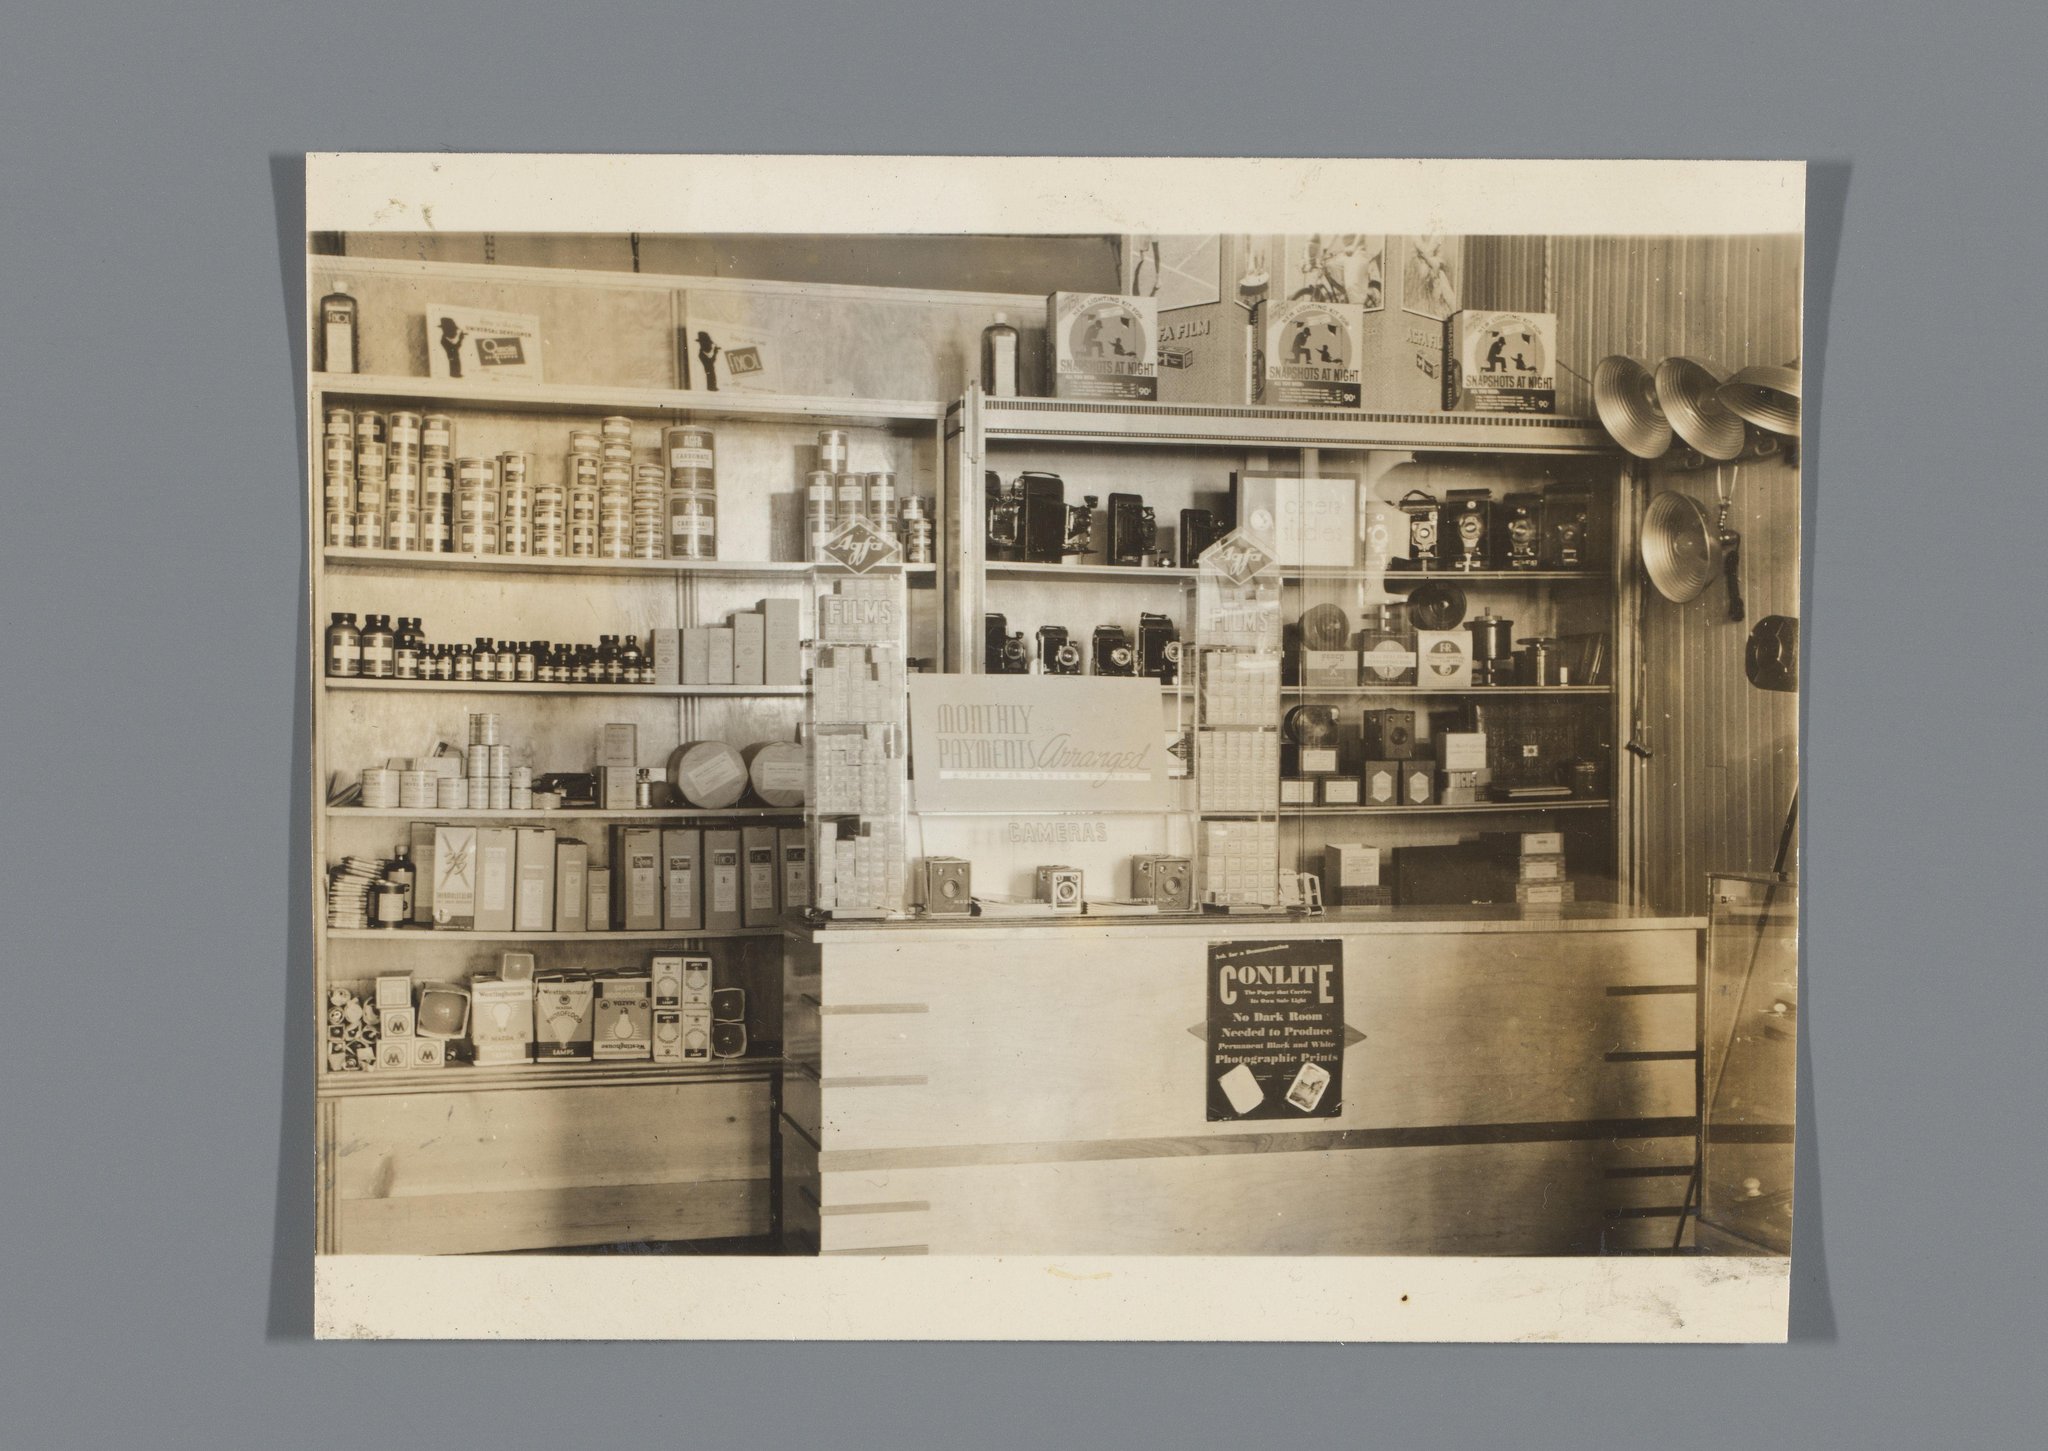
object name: photograph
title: Interieur van de Camera Shop in White Plains, New York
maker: Anonymous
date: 1939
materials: photographic support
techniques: gelatin silver print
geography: united states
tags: white plains, new york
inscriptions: stamp: ‘The Camera Shop / MAR 6 1939 / White Plains, N. Y.’